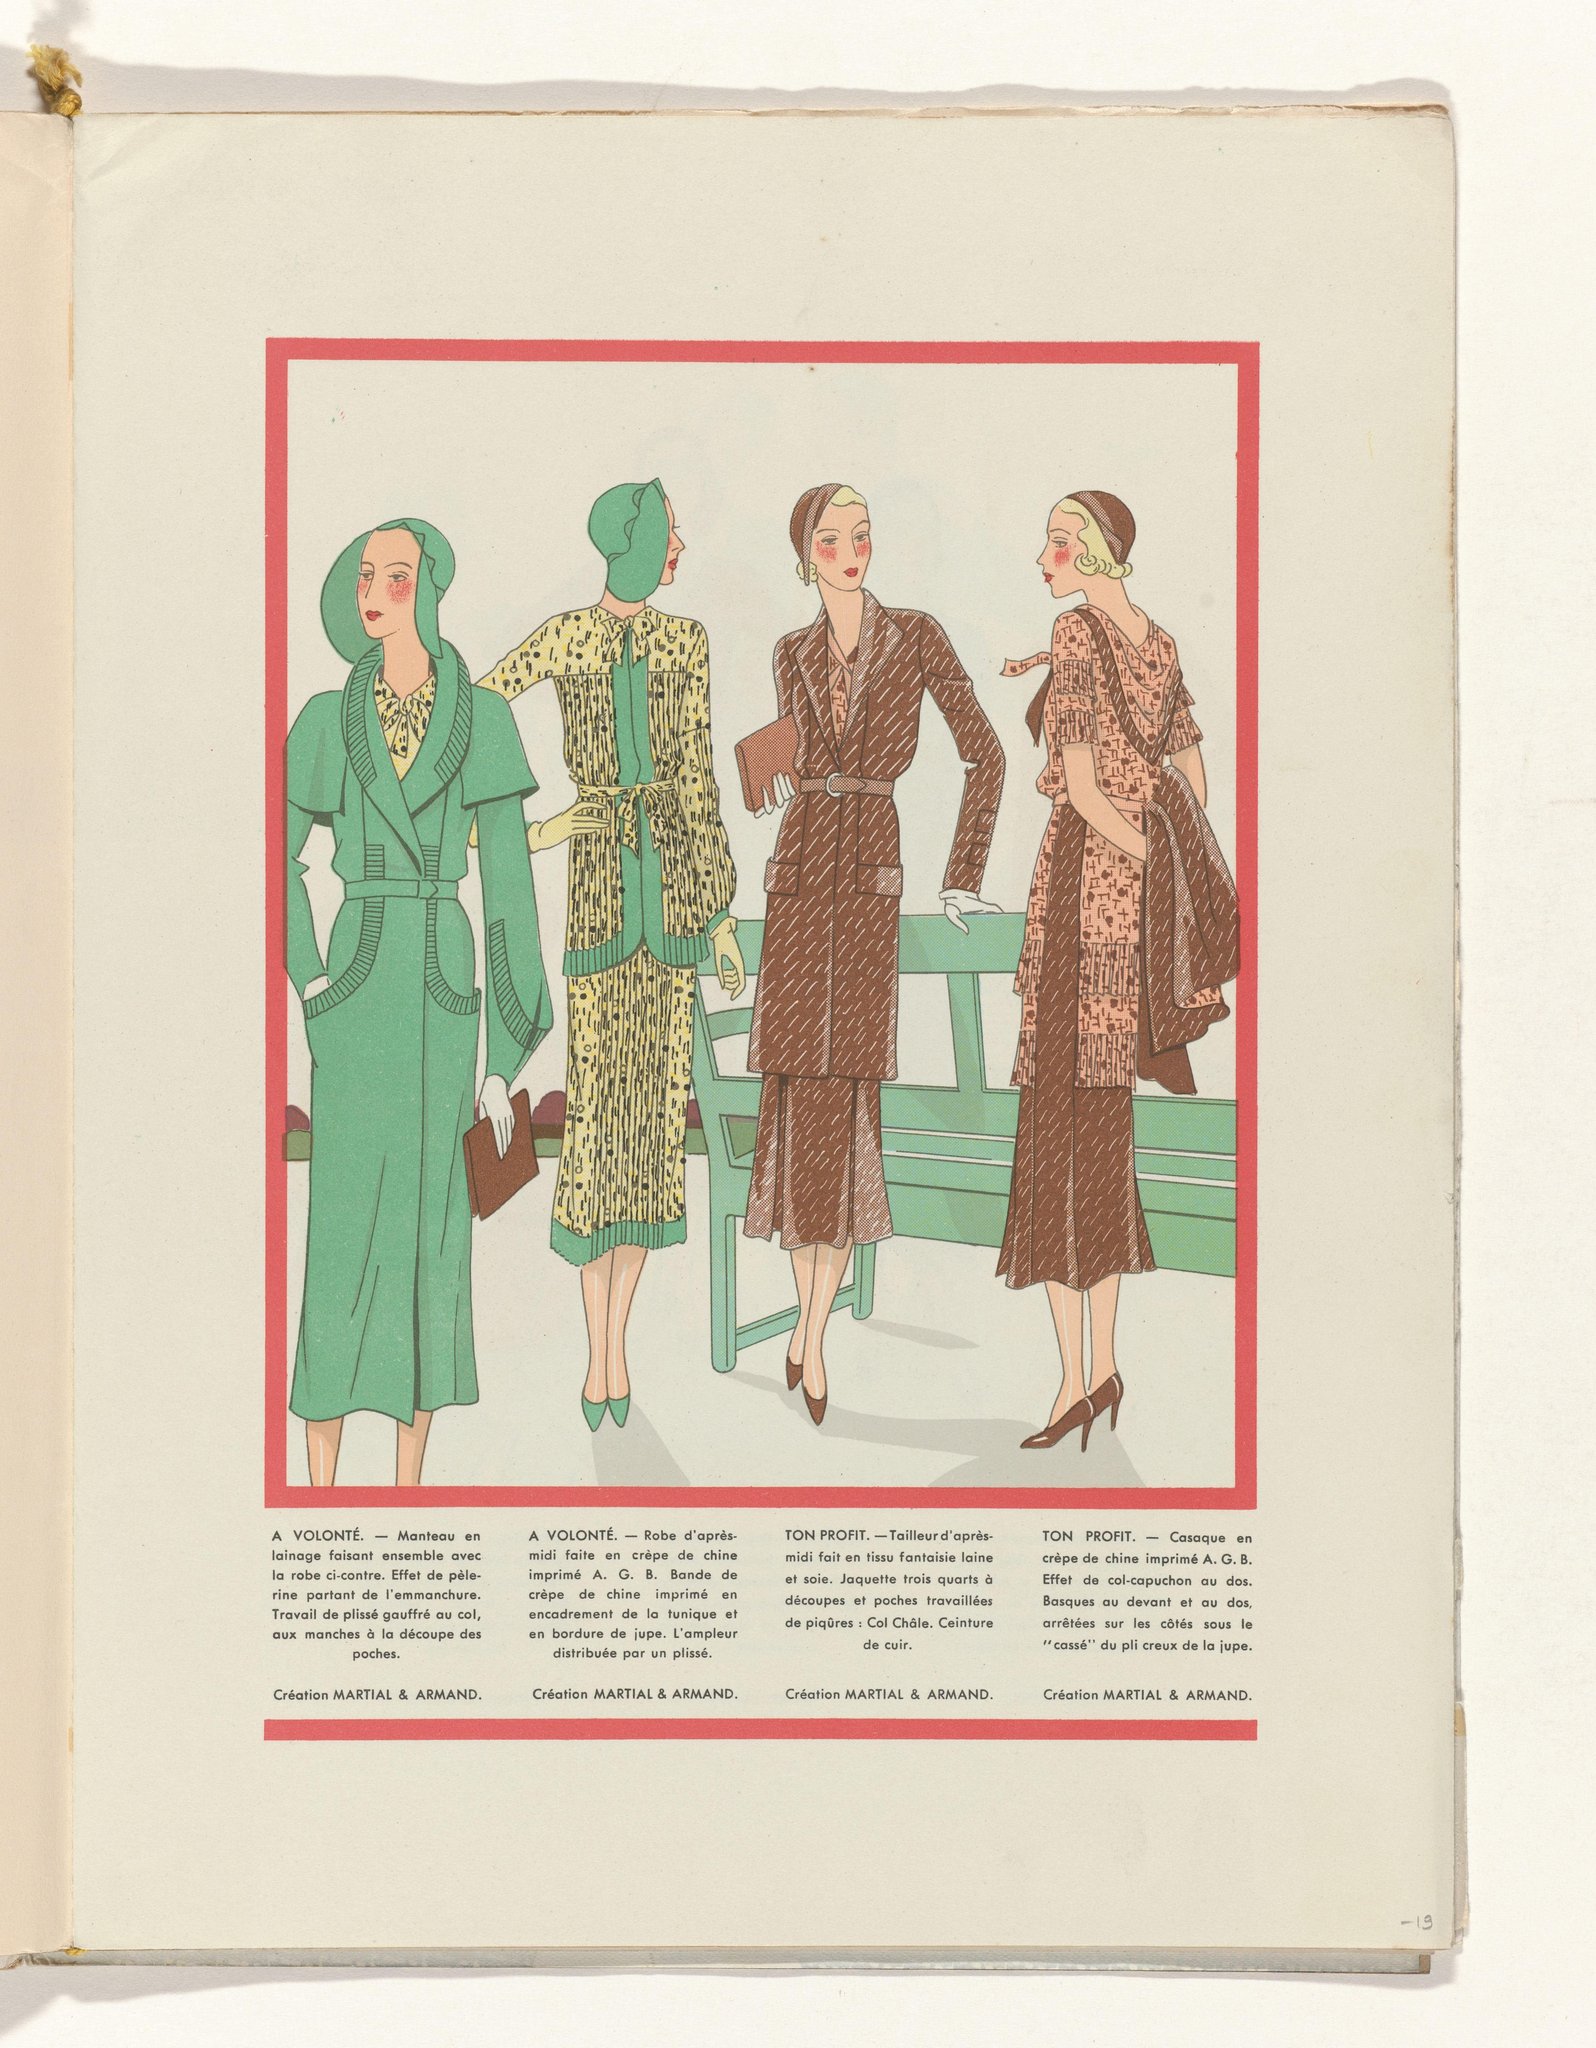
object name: magazine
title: Art - Goût - Beauté, Feuillets de l' élégance féminine, Mai 1931, No. 129, 11e Année, p. 19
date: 1931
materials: paper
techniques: printing, hand coloring, lithograph, photography, pochoir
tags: ensembles of pieces of clothing (suit) (+ women's clothes), dress, gown: day dress (+ women's clothes), clothing for the upper part of the body (casaque) (+ women's clothes), coat (+ women's clothes), fashion plates, head-gear: hat (+ women's clothes)